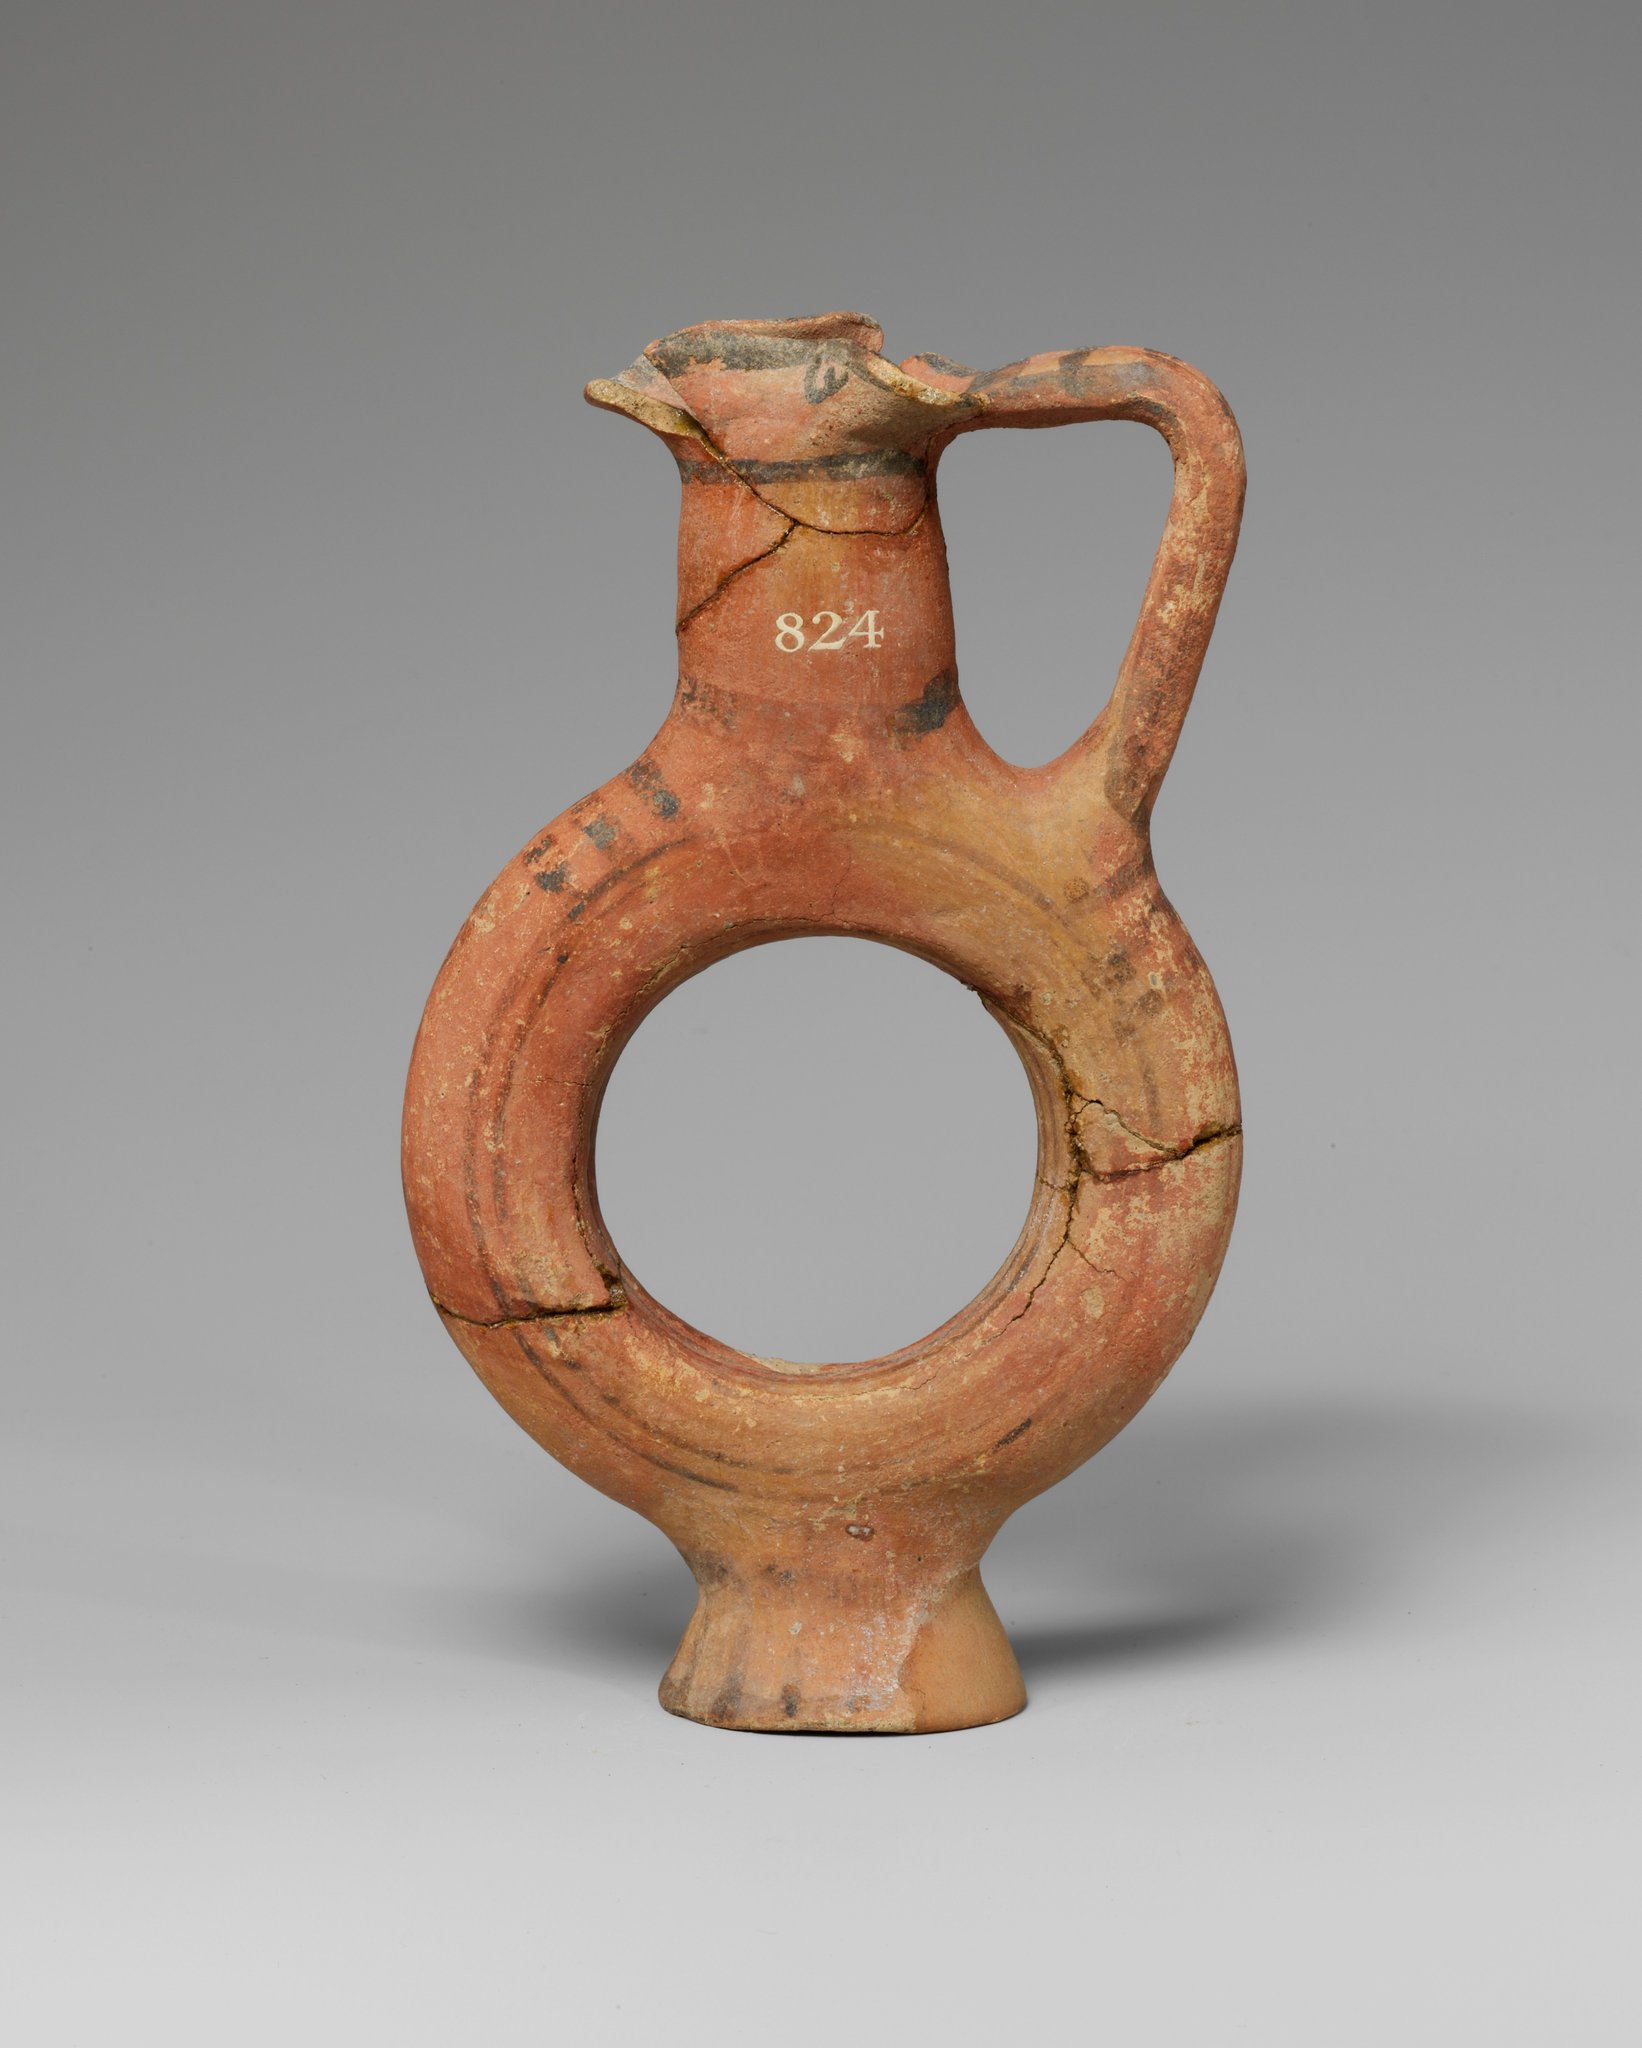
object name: ring flask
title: Terracotta flask with ring-shaped body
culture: cypriot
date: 850-600 BCE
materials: terracotta